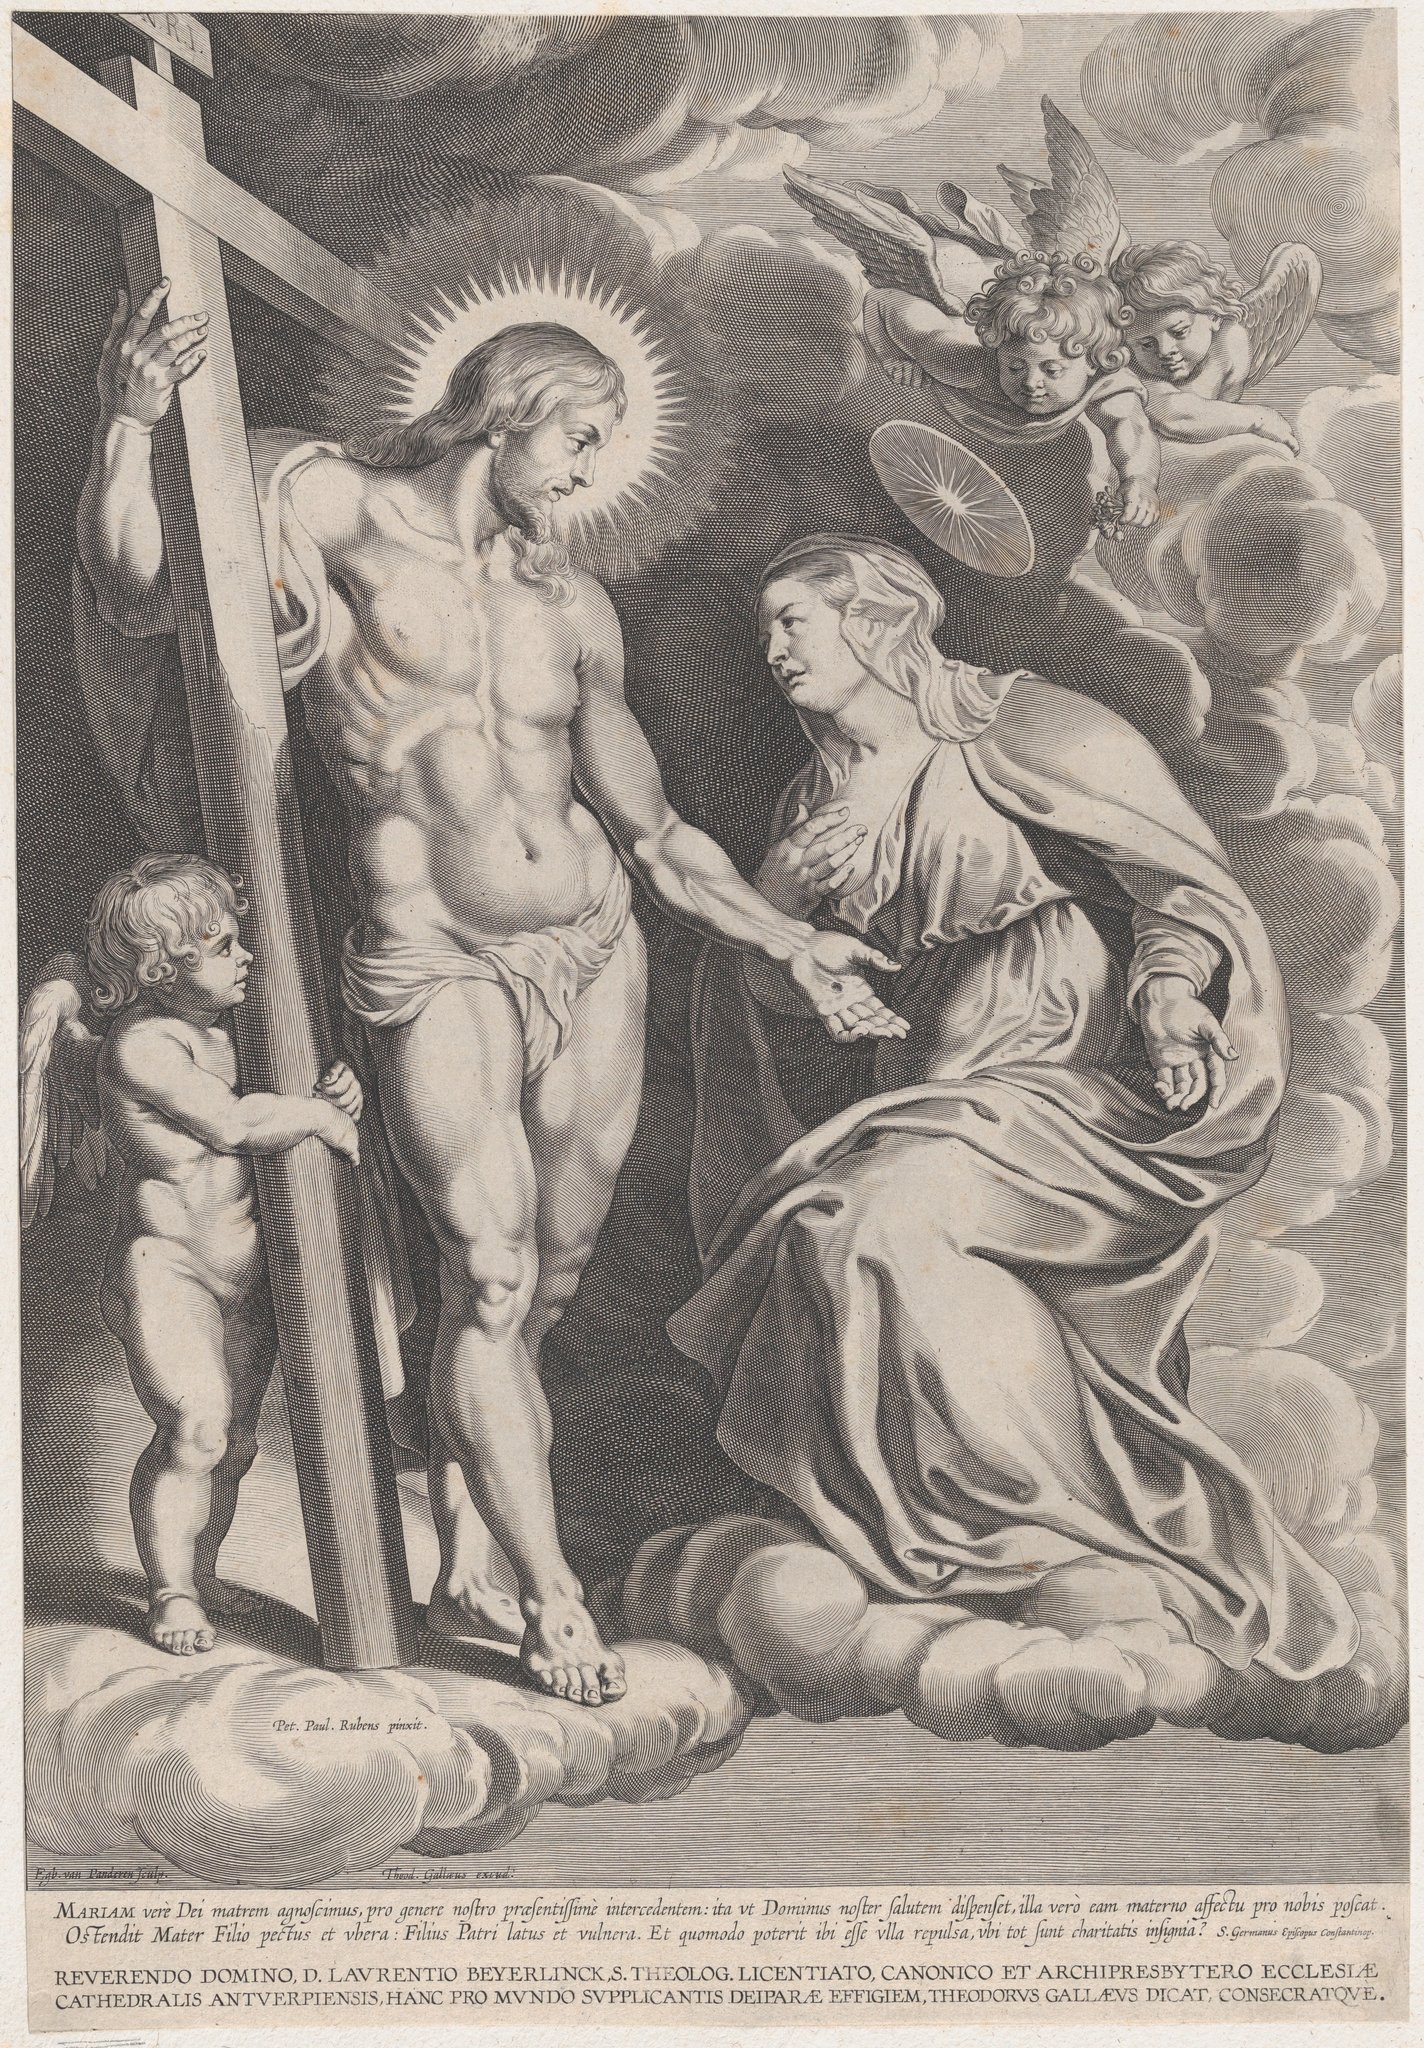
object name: print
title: The Intercession of the Virgin, kneeling on a cloud at right before Christ, standing at left holding the cross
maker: egbert van panderen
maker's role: artist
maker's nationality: flemish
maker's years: 1590-1637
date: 1610-1637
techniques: engraving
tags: putti,christ,virgin mary,cross